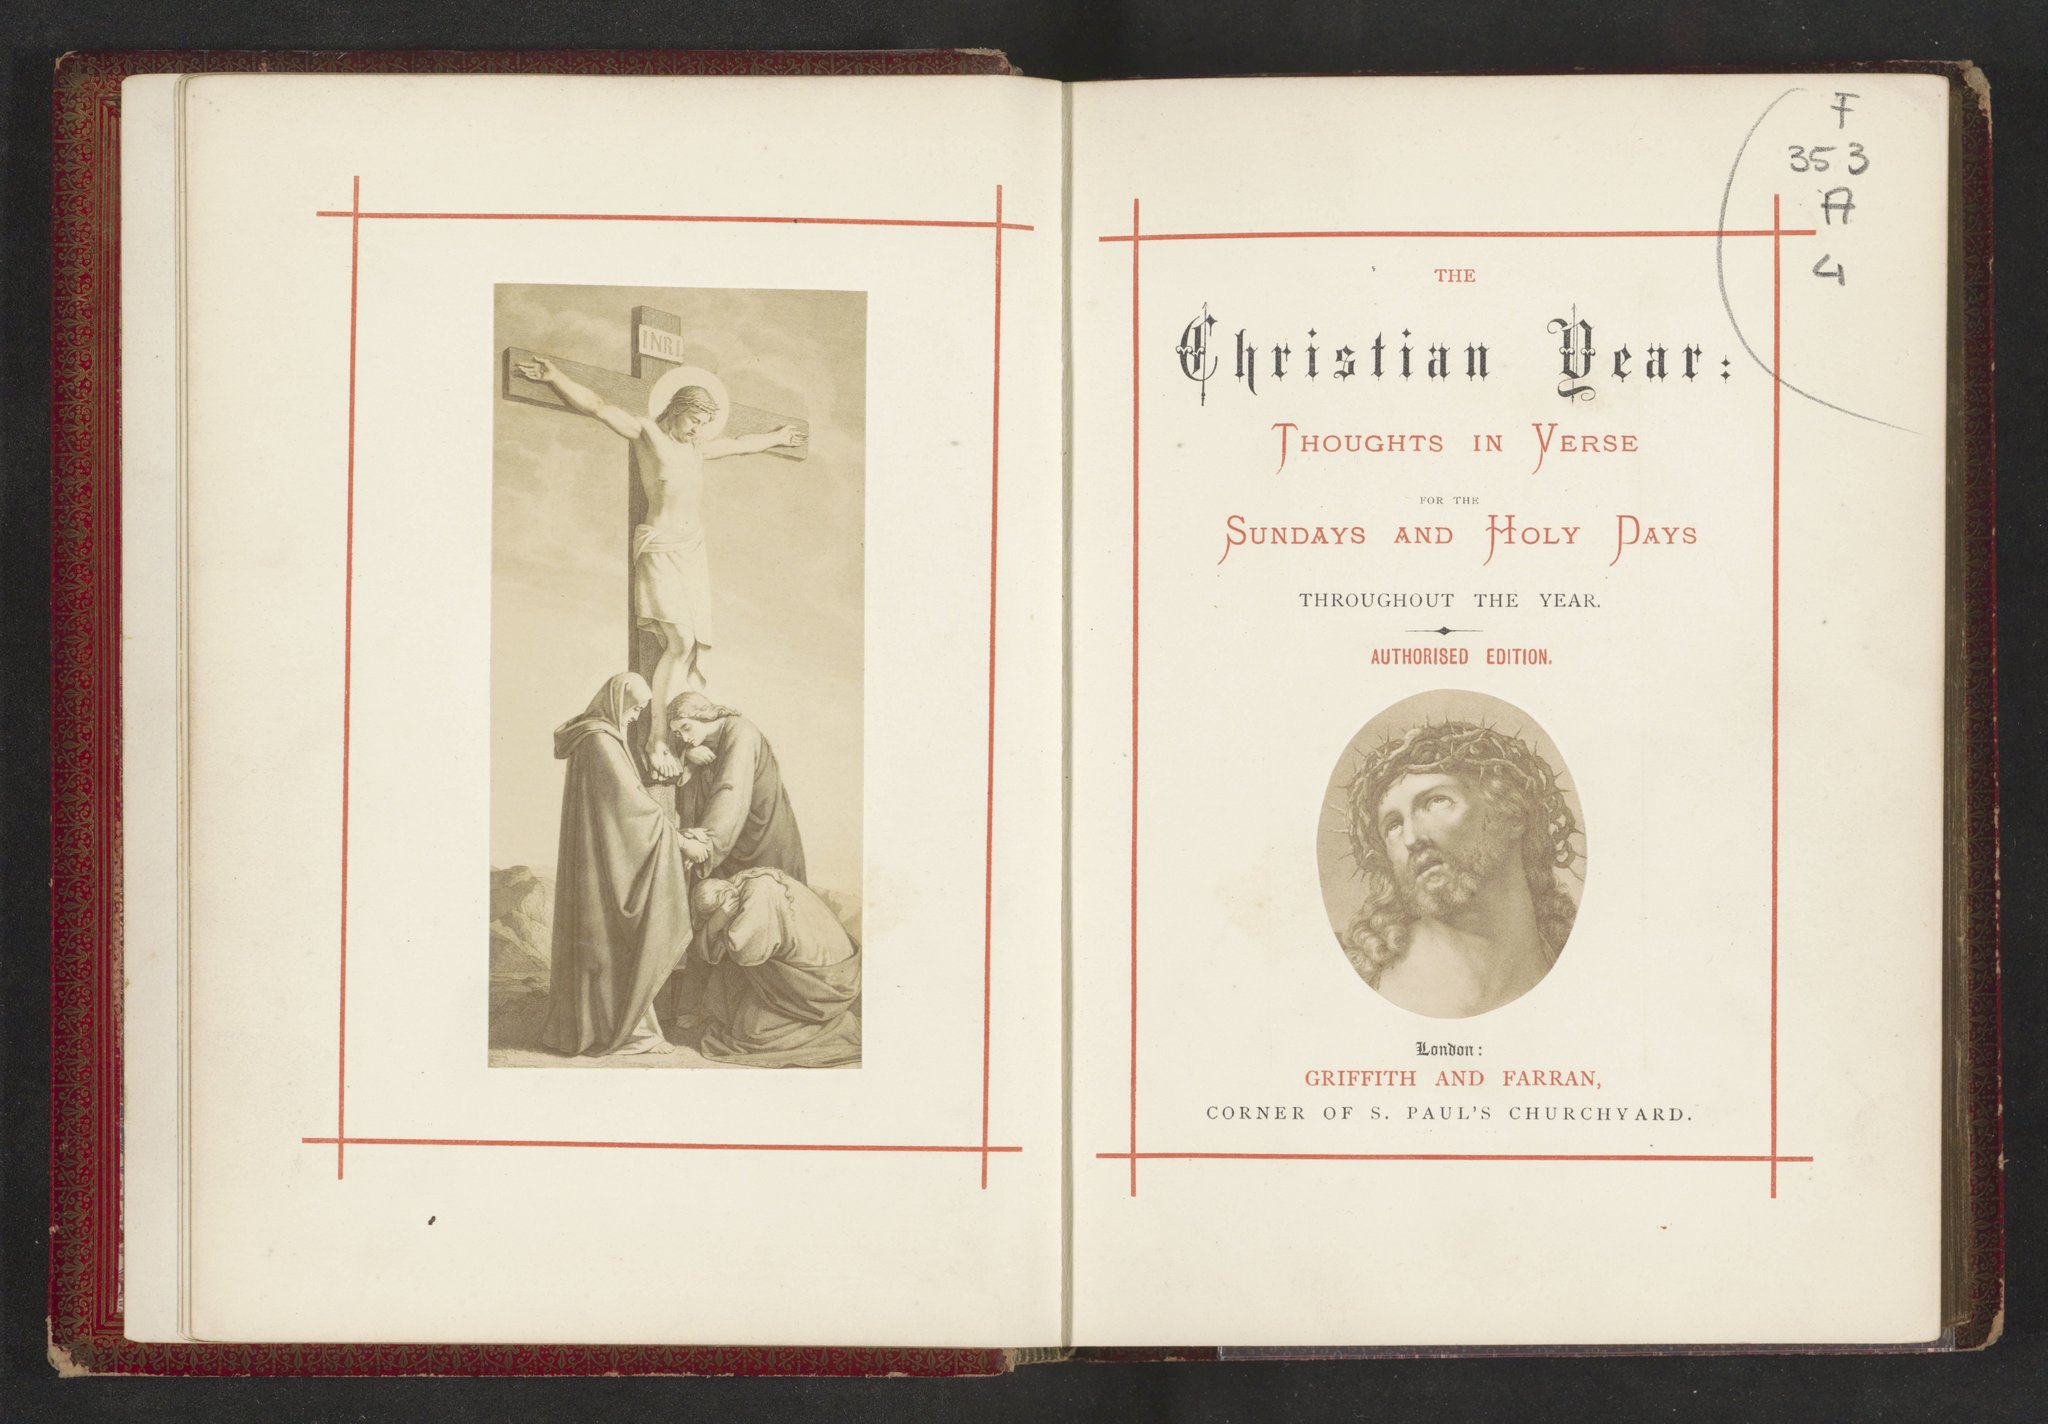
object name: page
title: Fotoreproductie van een prent, voorstellende het hoofd van Christus met de doornenkroon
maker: Anonymous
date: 1868-1873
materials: photographic support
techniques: albumen print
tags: head of christ with crown of thorns